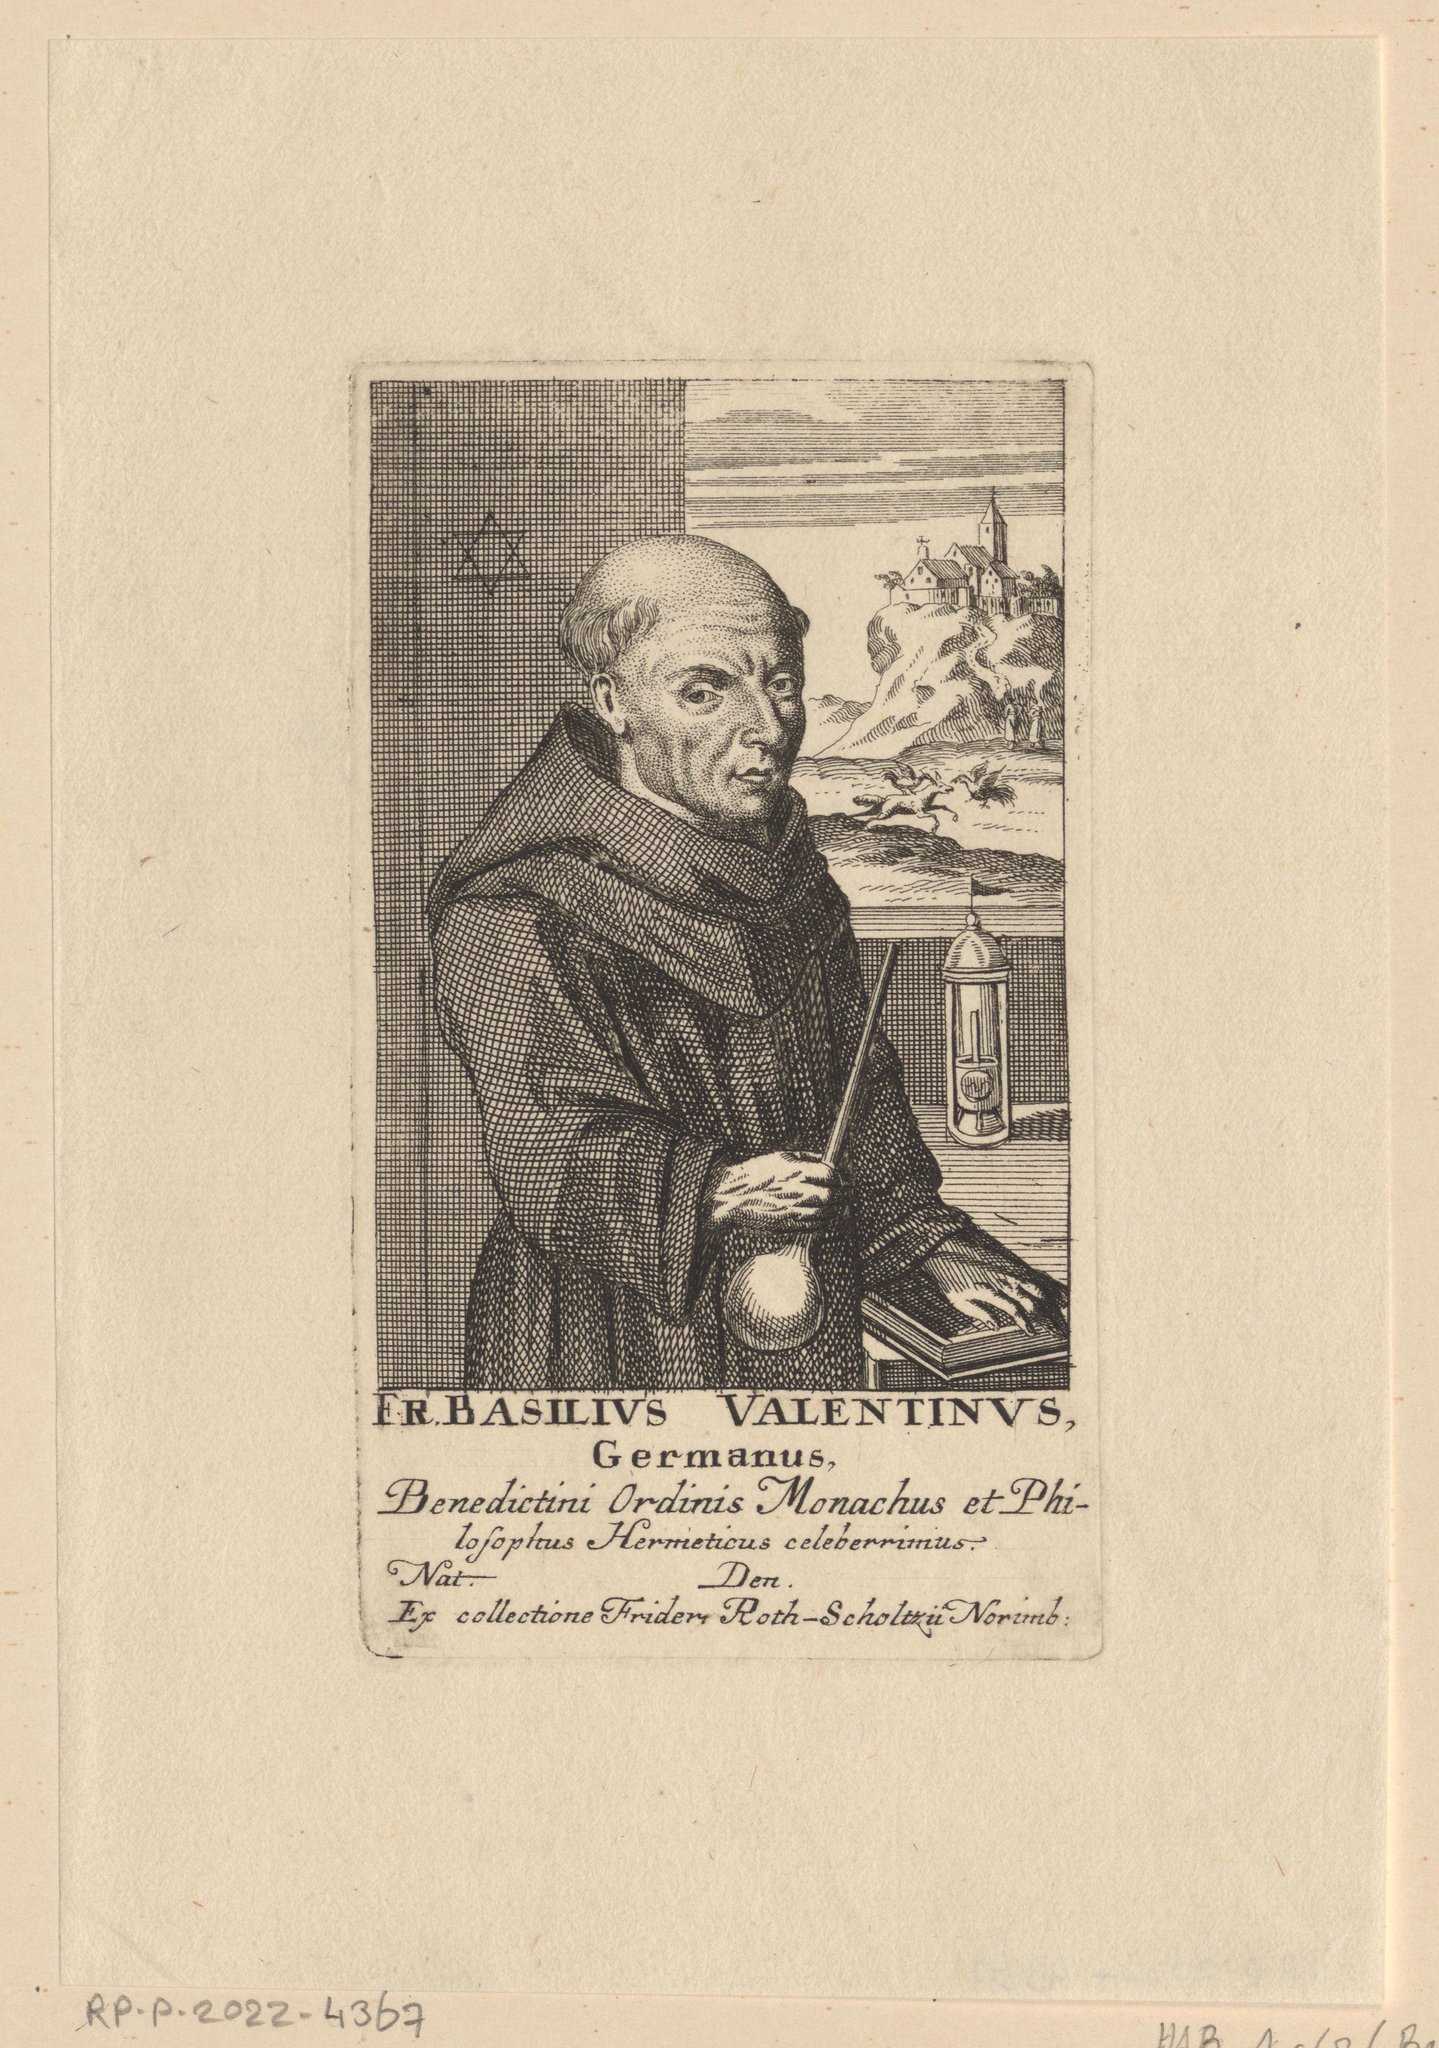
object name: print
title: Portret van Basilius Valentinus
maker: Anonymous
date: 1700-1799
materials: paper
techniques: etching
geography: germany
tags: alchemistic symbols, alchemistic equipment, portrait of a writer, monk(s), friar(s), book